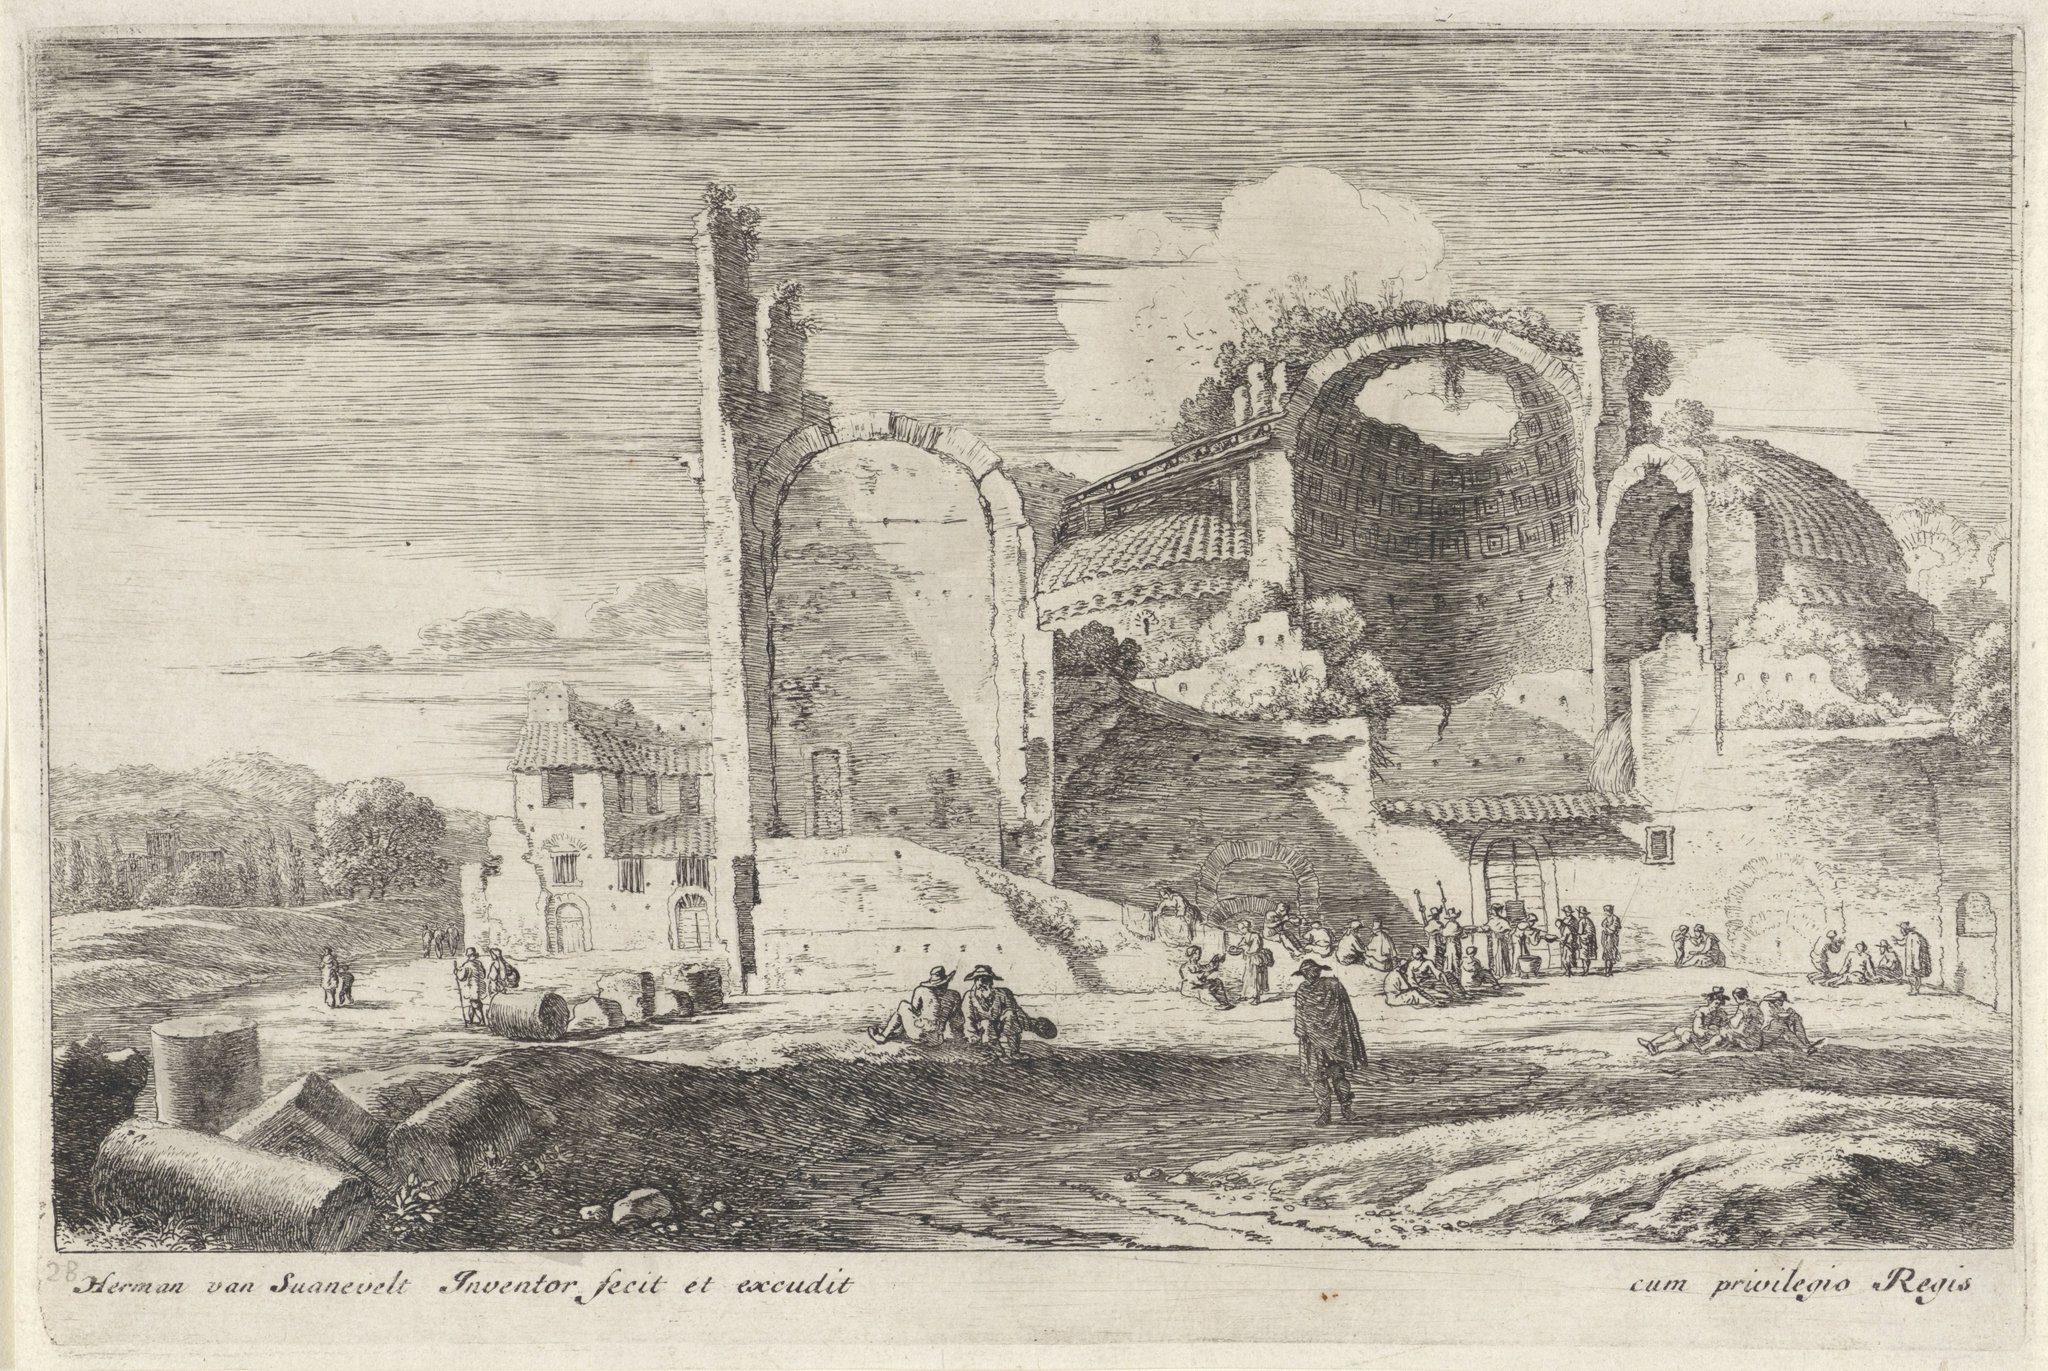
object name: print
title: Twaalf landschappen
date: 1650-1655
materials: paper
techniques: etching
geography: paris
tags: giving alms or other charity, e.g.: handing out food, landscapes, ruin of a building ~ architecture, landscape with ruins, bread, loaf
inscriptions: collector's mark: Lugt 240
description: Voor een klassieke ruïne met koepels en een cassettenplafond delen twee vrouwen brood uit aan enkele figuren. Vooraan rusten enkele figuren en liggen een paar gebroken zuilen.